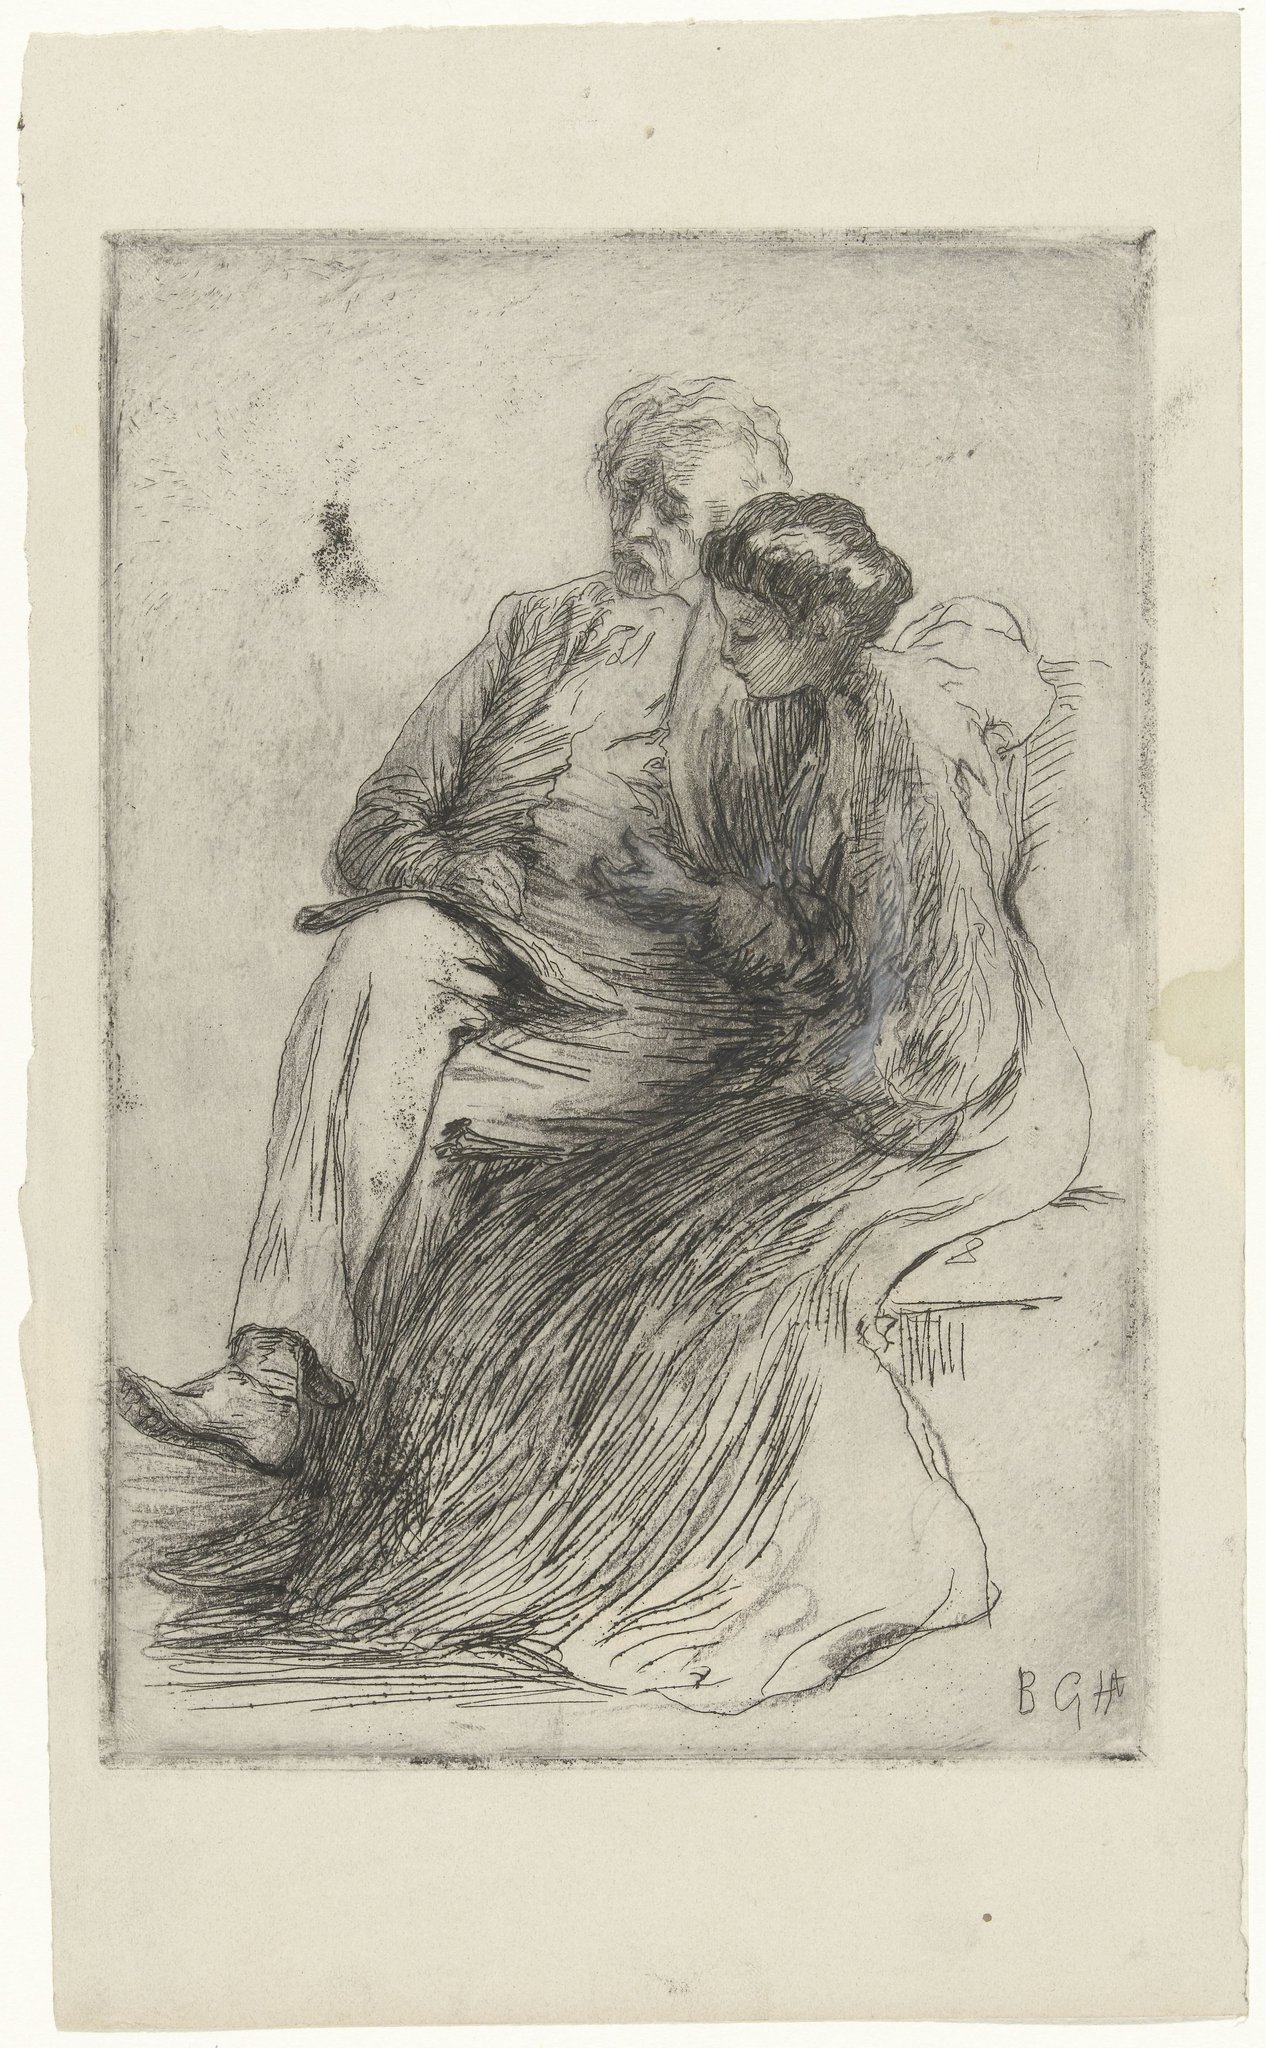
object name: print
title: Lezende jonge vrouw en oudere man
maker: a.a.l. de grammont-hubrecht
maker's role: draughtsman, painter, print maker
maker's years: 1855-1913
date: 1892-1913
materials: chalk, paint, paper, pencil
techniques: etching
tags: adolescent, young woman, maiden, reading, adult man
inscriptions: collector's mark: Lugt 2228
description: Naast elkaar zitten een oudere man en een jonge vrouw rechts van hem. De man met een boek op schoot, de vrouw leest mee.